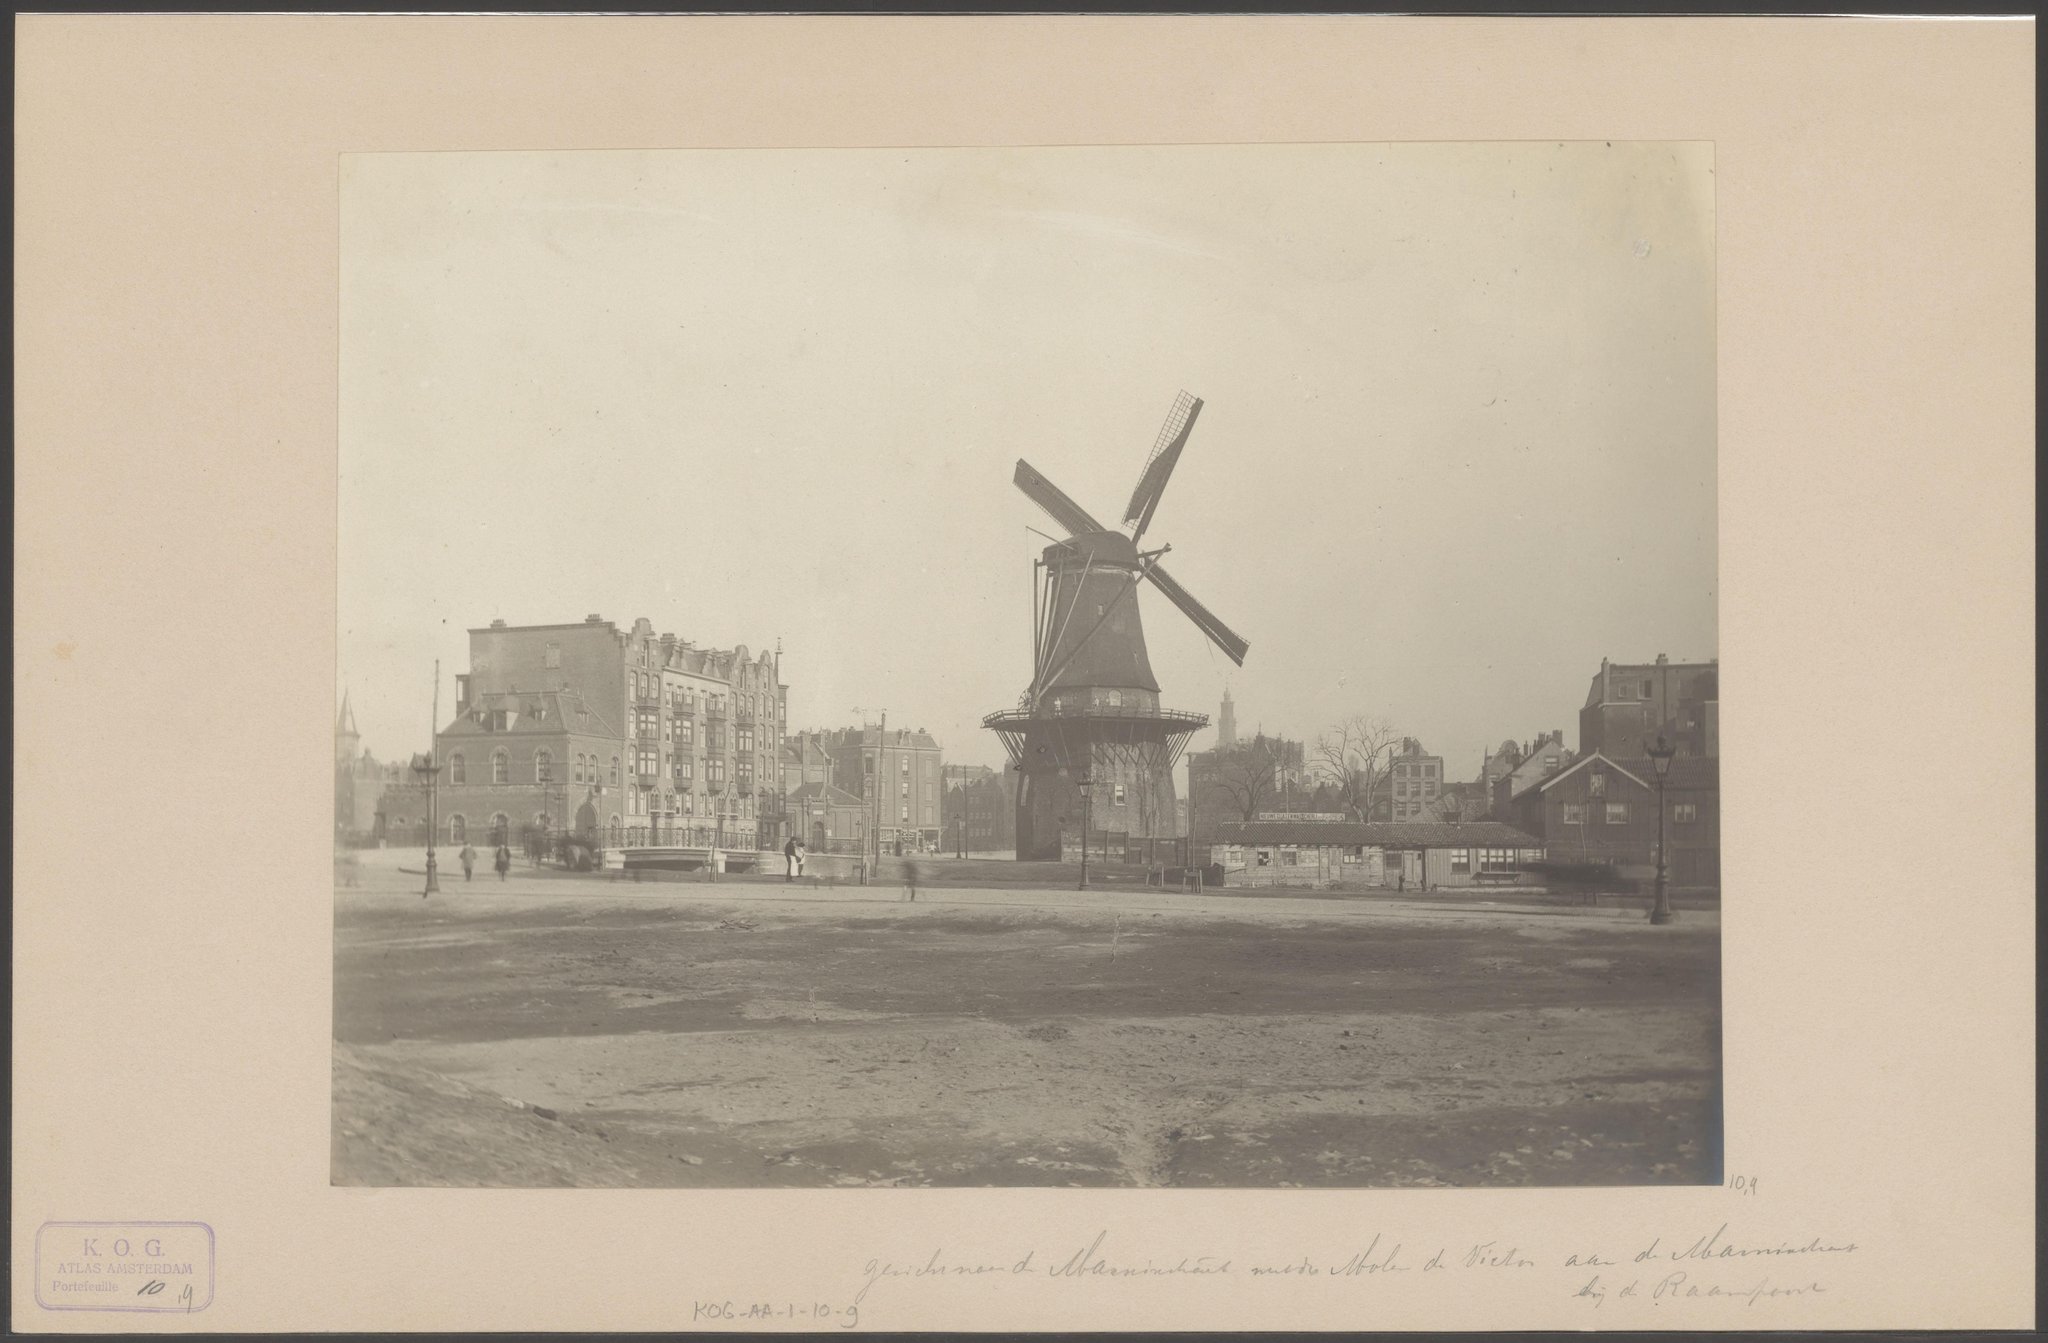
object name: photograph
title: Gezicht op de Marnixstraat met molen De Victor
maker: Anonymous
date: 1880-1898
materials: paper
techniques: gelatin silver print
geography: amsterdam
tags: city-view in general; 'veduta', windmill in landscape, the usual house or row of houses, street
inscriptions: inscription: ‘gezicht naar de Marnixstraat naar de Molen de Victor aan de Marnixstraat / bij de Raampoort’, collector's mark: ‘10,9’ Lugt 1641b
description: Onderwerpsrubriek binnen de Atlas Amsterdam: Maagdelievenstraat, Markenplein, Marnixstraat, Martelaarsgracht, Meeuwenlaan, Mennonietenpad, Meijerplein (Jonas Daniël), Mozes en Aäronstraat, Muidergracht, Muntplein.